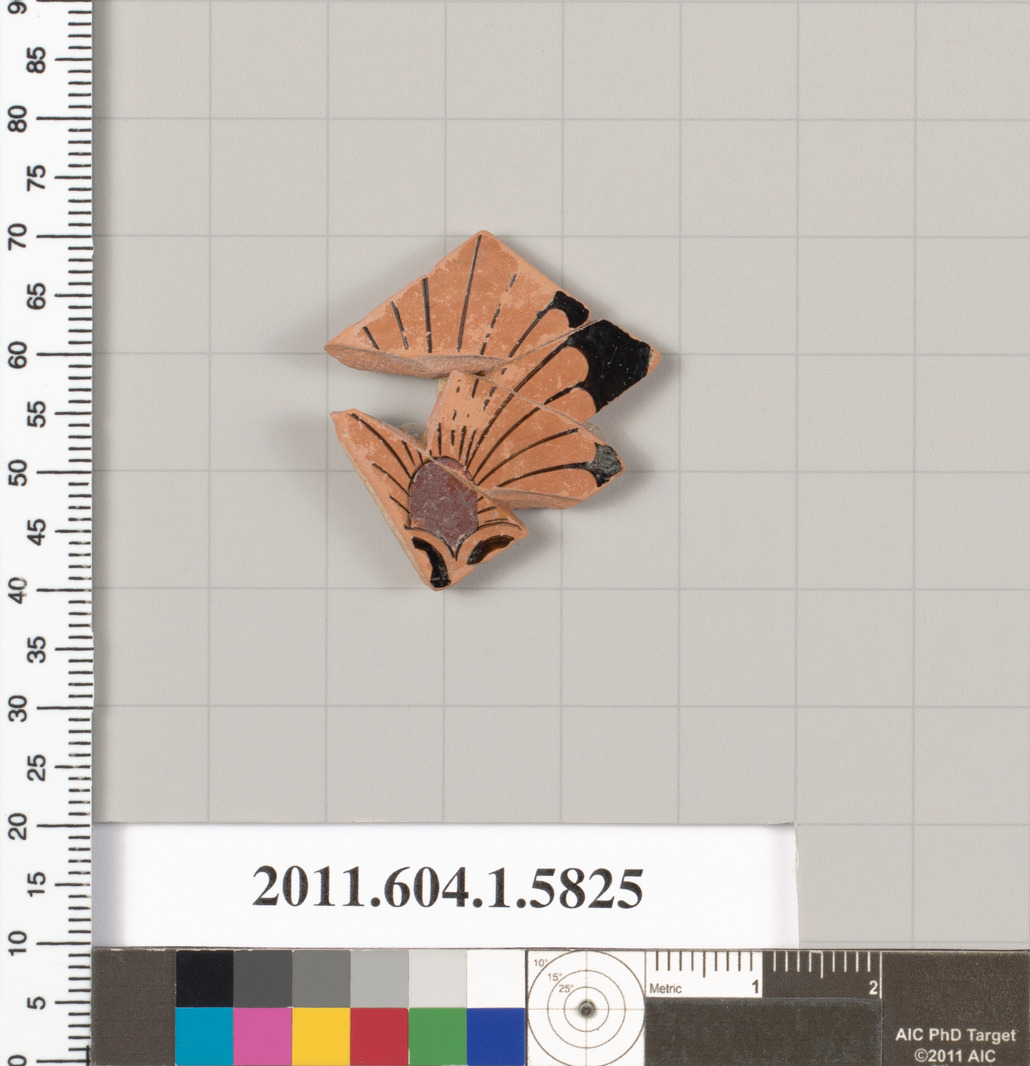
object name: kylix fragment, eye cup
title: Terracotta fragment of a kylix: eye-cup (drinking cup)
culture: greek, attic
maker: psiax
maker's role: artist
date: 520-510 BCE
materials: terracotta